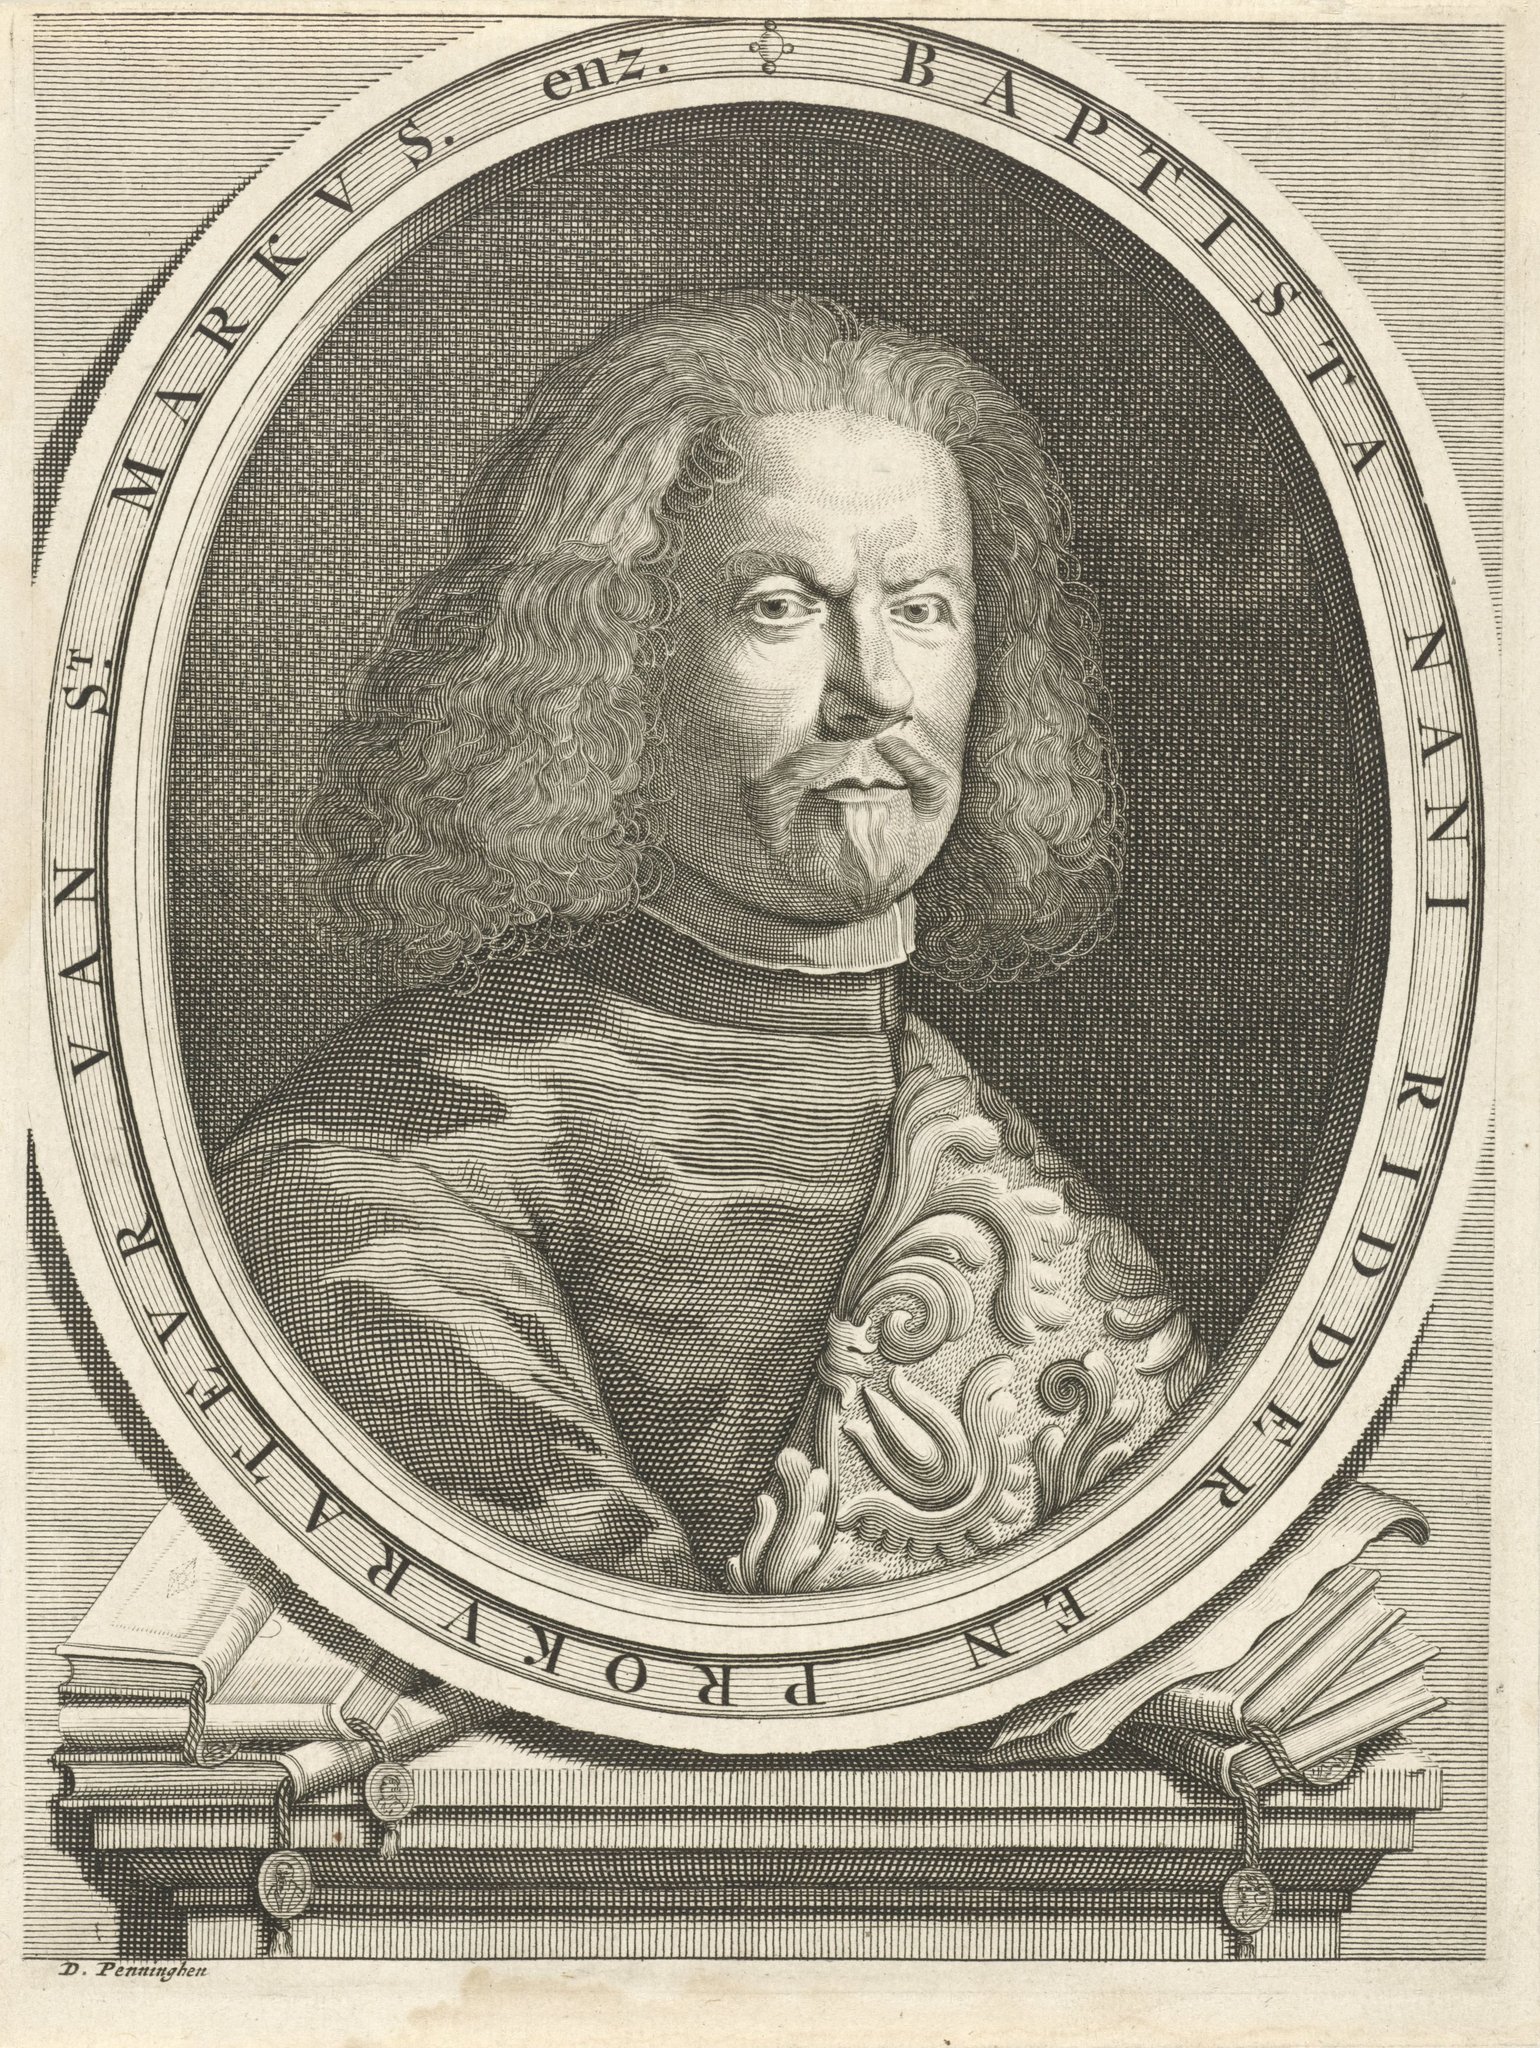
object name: print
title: Portret van Baptista Nani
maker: daniël met de penningen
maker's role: print maker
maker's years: -1696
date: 1685-1696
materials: paper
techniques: engraving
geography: amsterdam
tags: book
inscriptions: collector's mark: Lugt 2228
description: Portret van de Venetiaanse schrijver Baptista Nani. De omlijsting van zijn portret rust op een piëdestal waarop allerlei boeken.